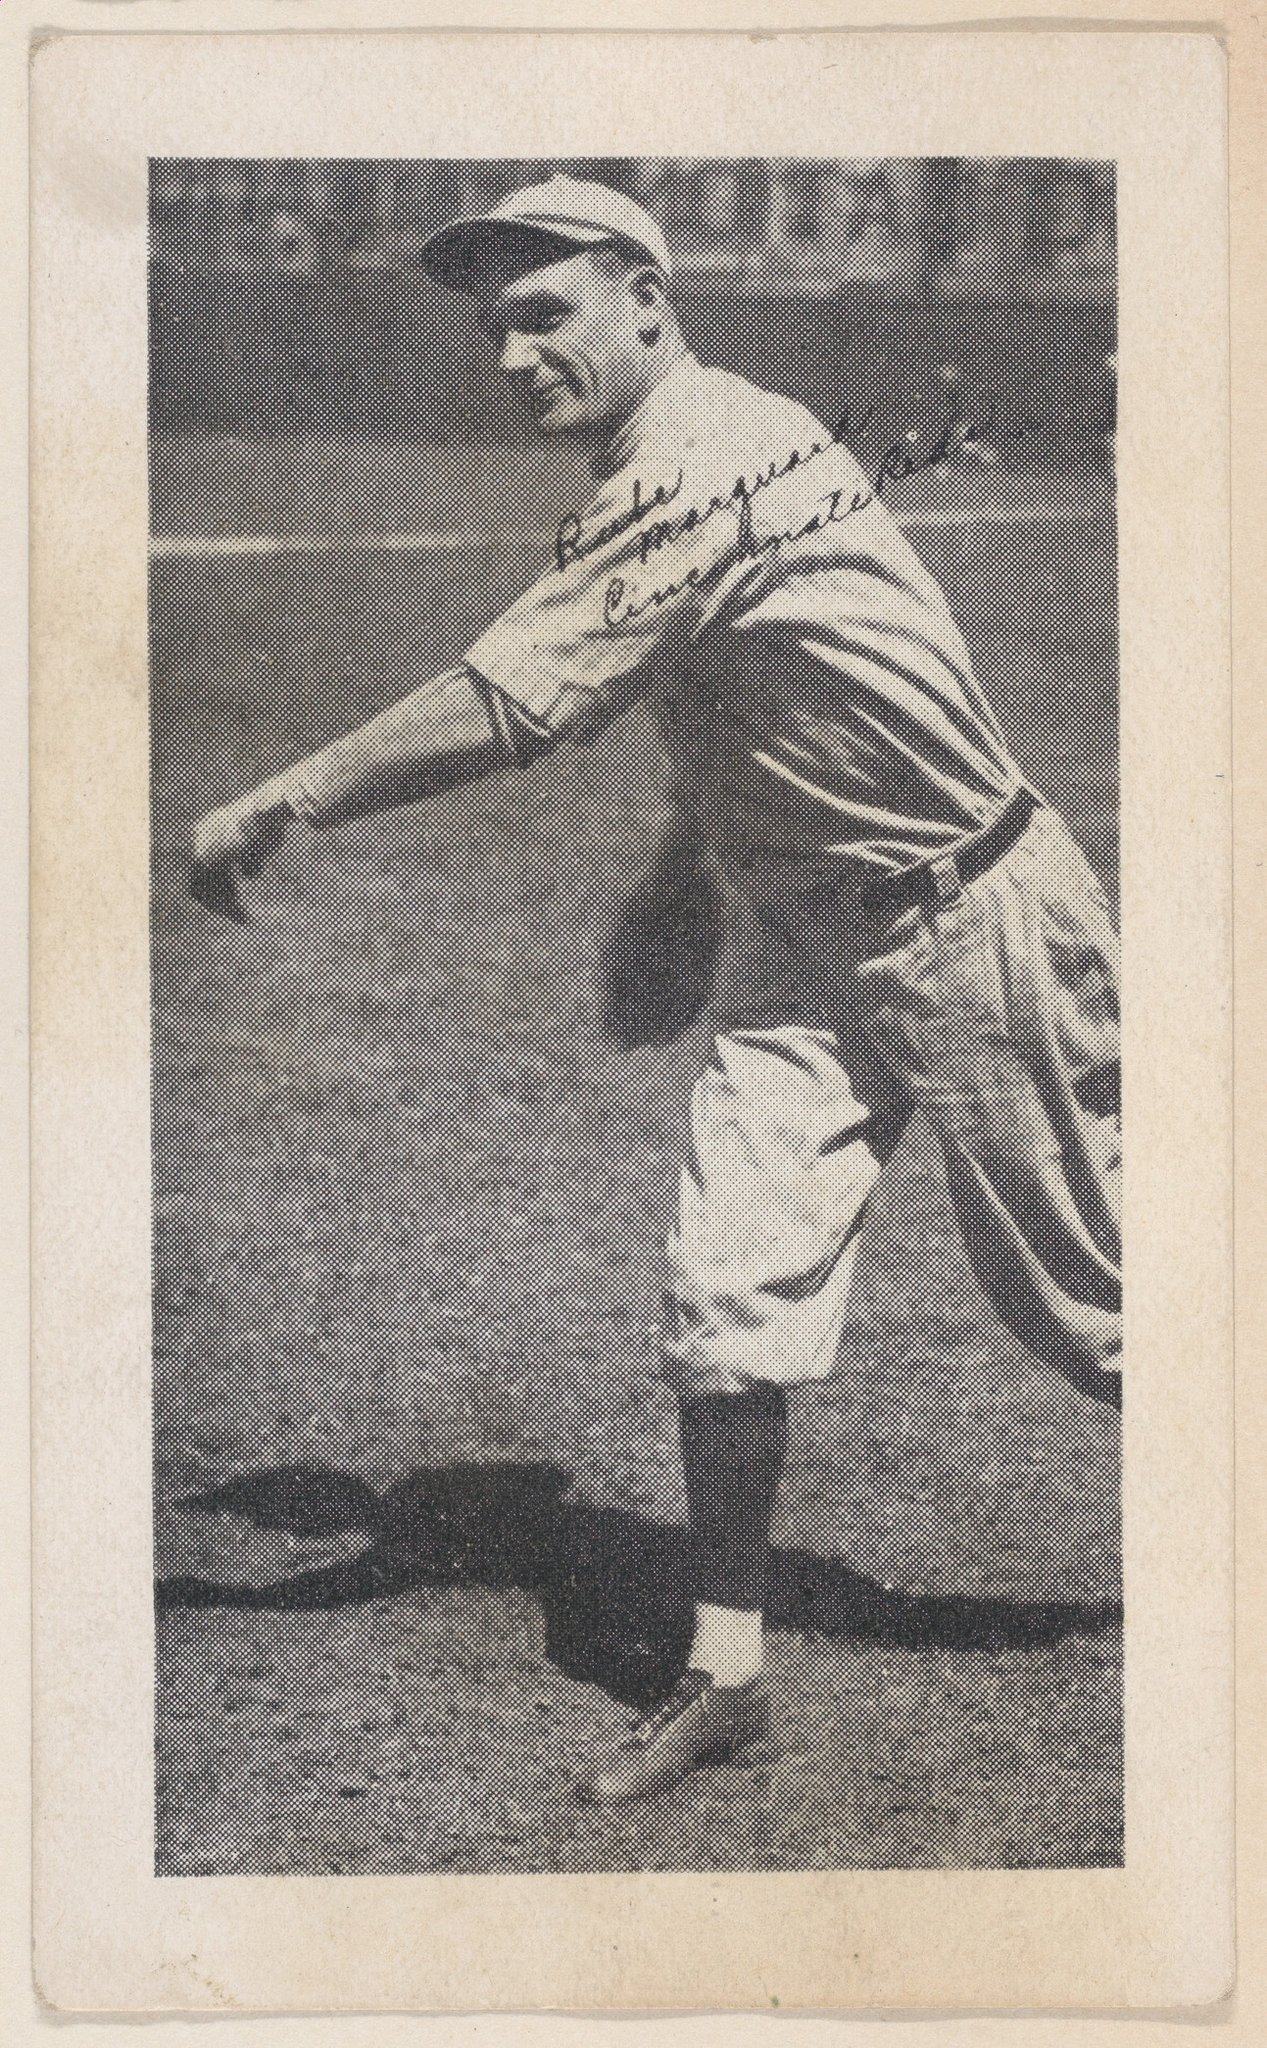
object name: print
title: Rube Marquard, Cincinnati Reds, from Baseball strip cards (W575-2)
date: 1921-1922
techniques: photolithograph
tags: men,portraits,baseball,athletes